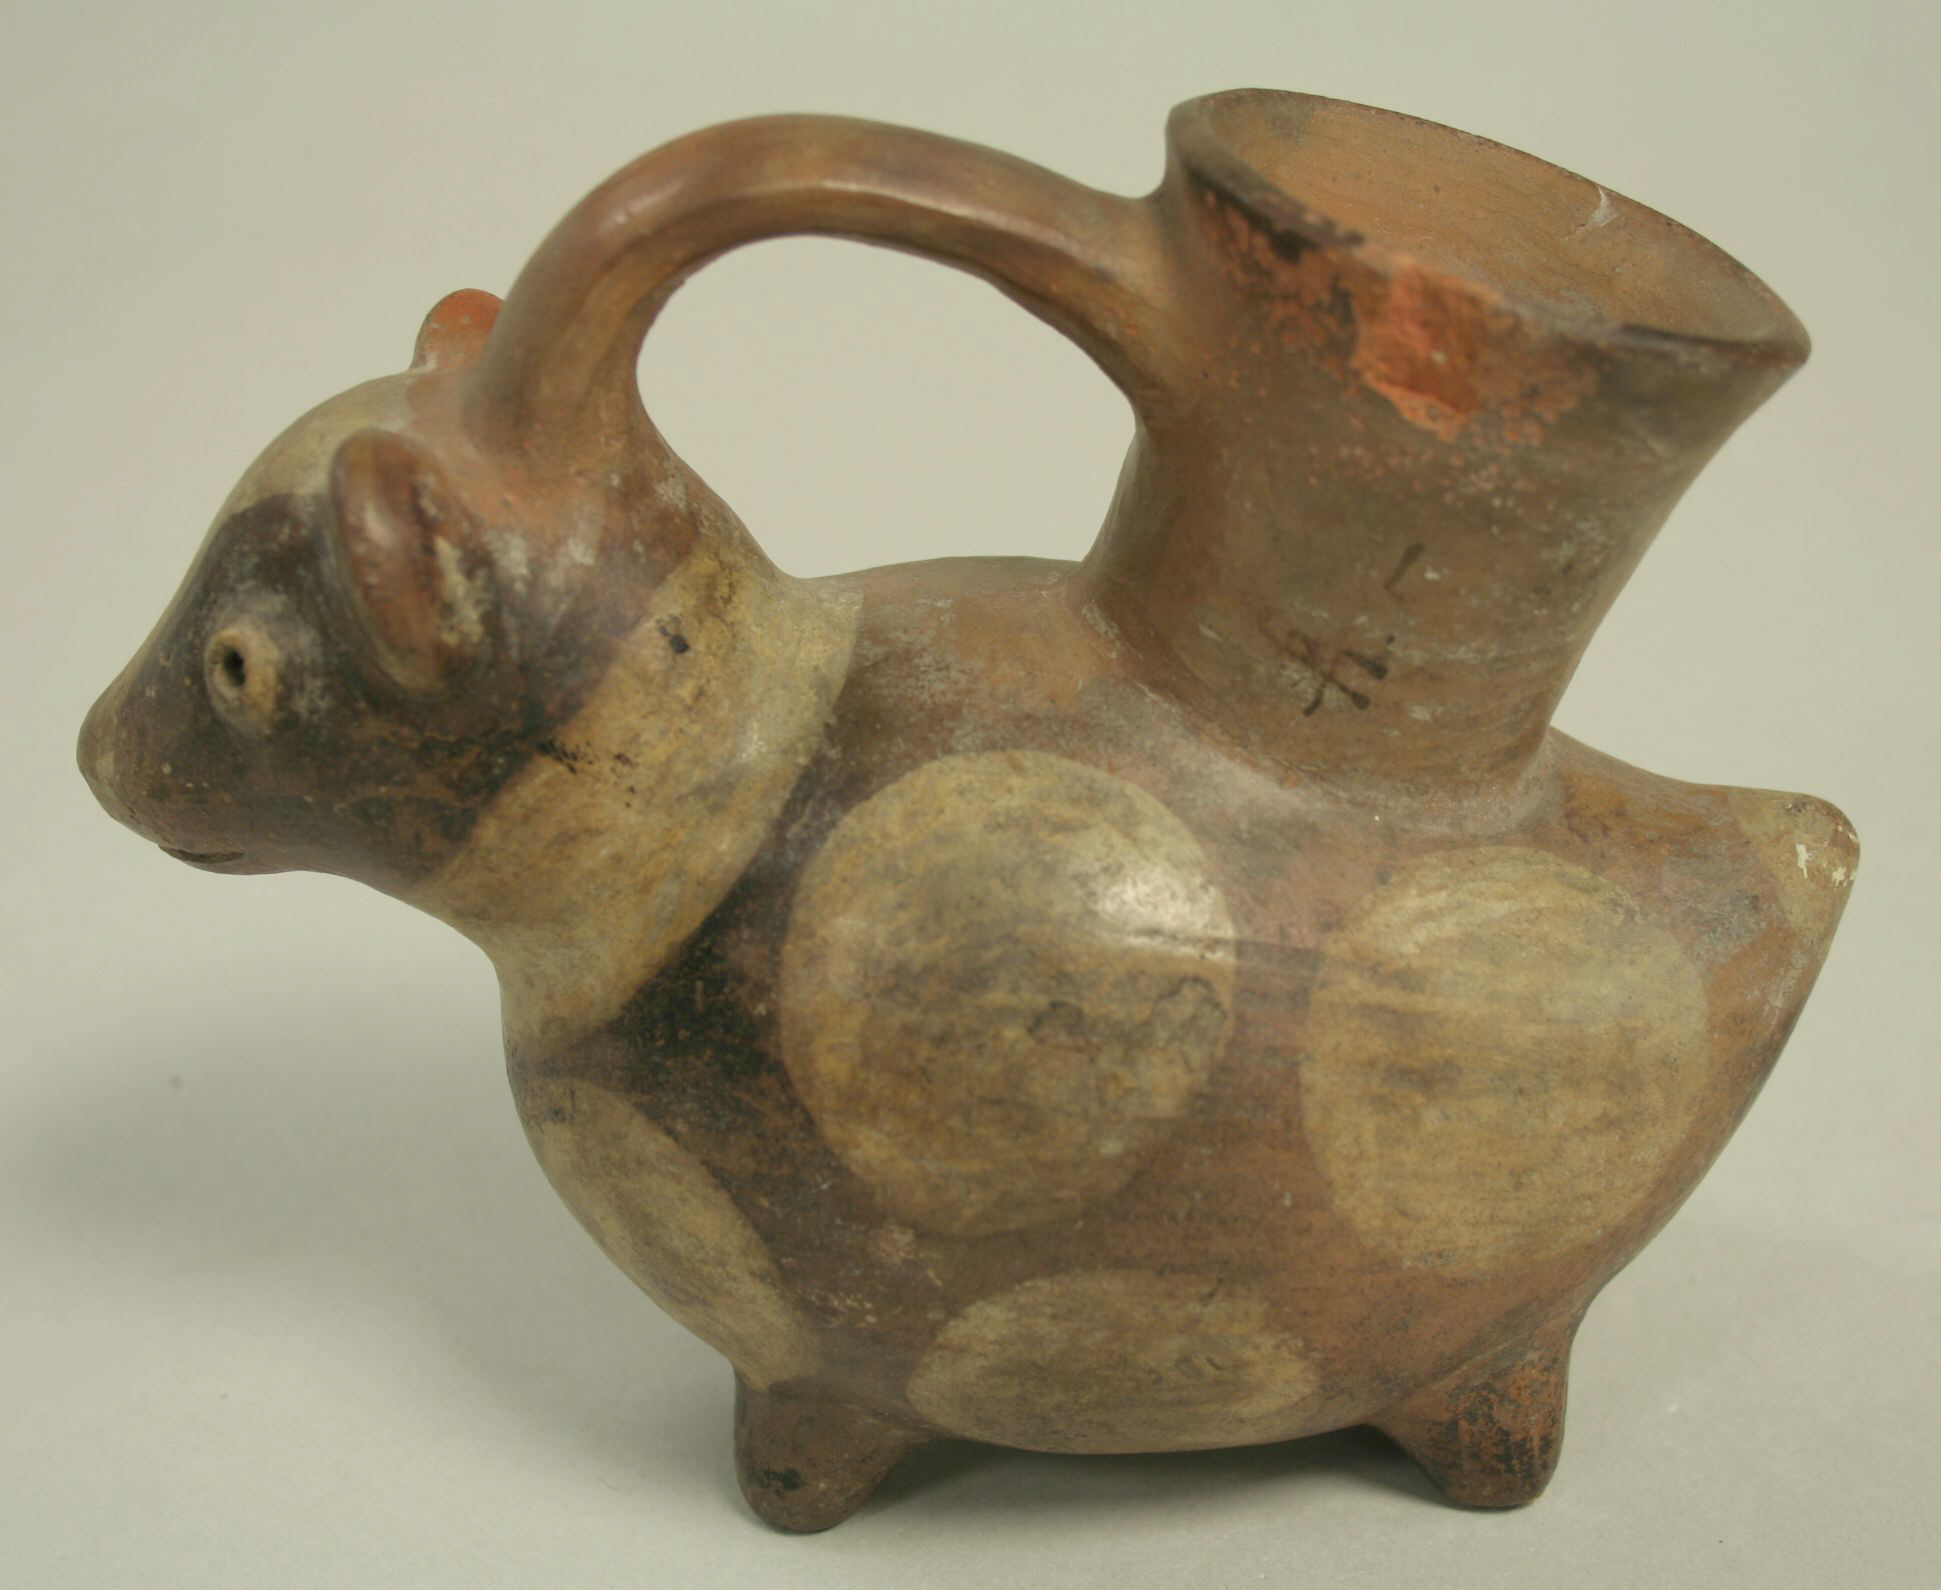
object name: bottle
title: Animal Bottle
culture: moche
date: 200-900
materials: ceramic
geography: peru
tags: animals